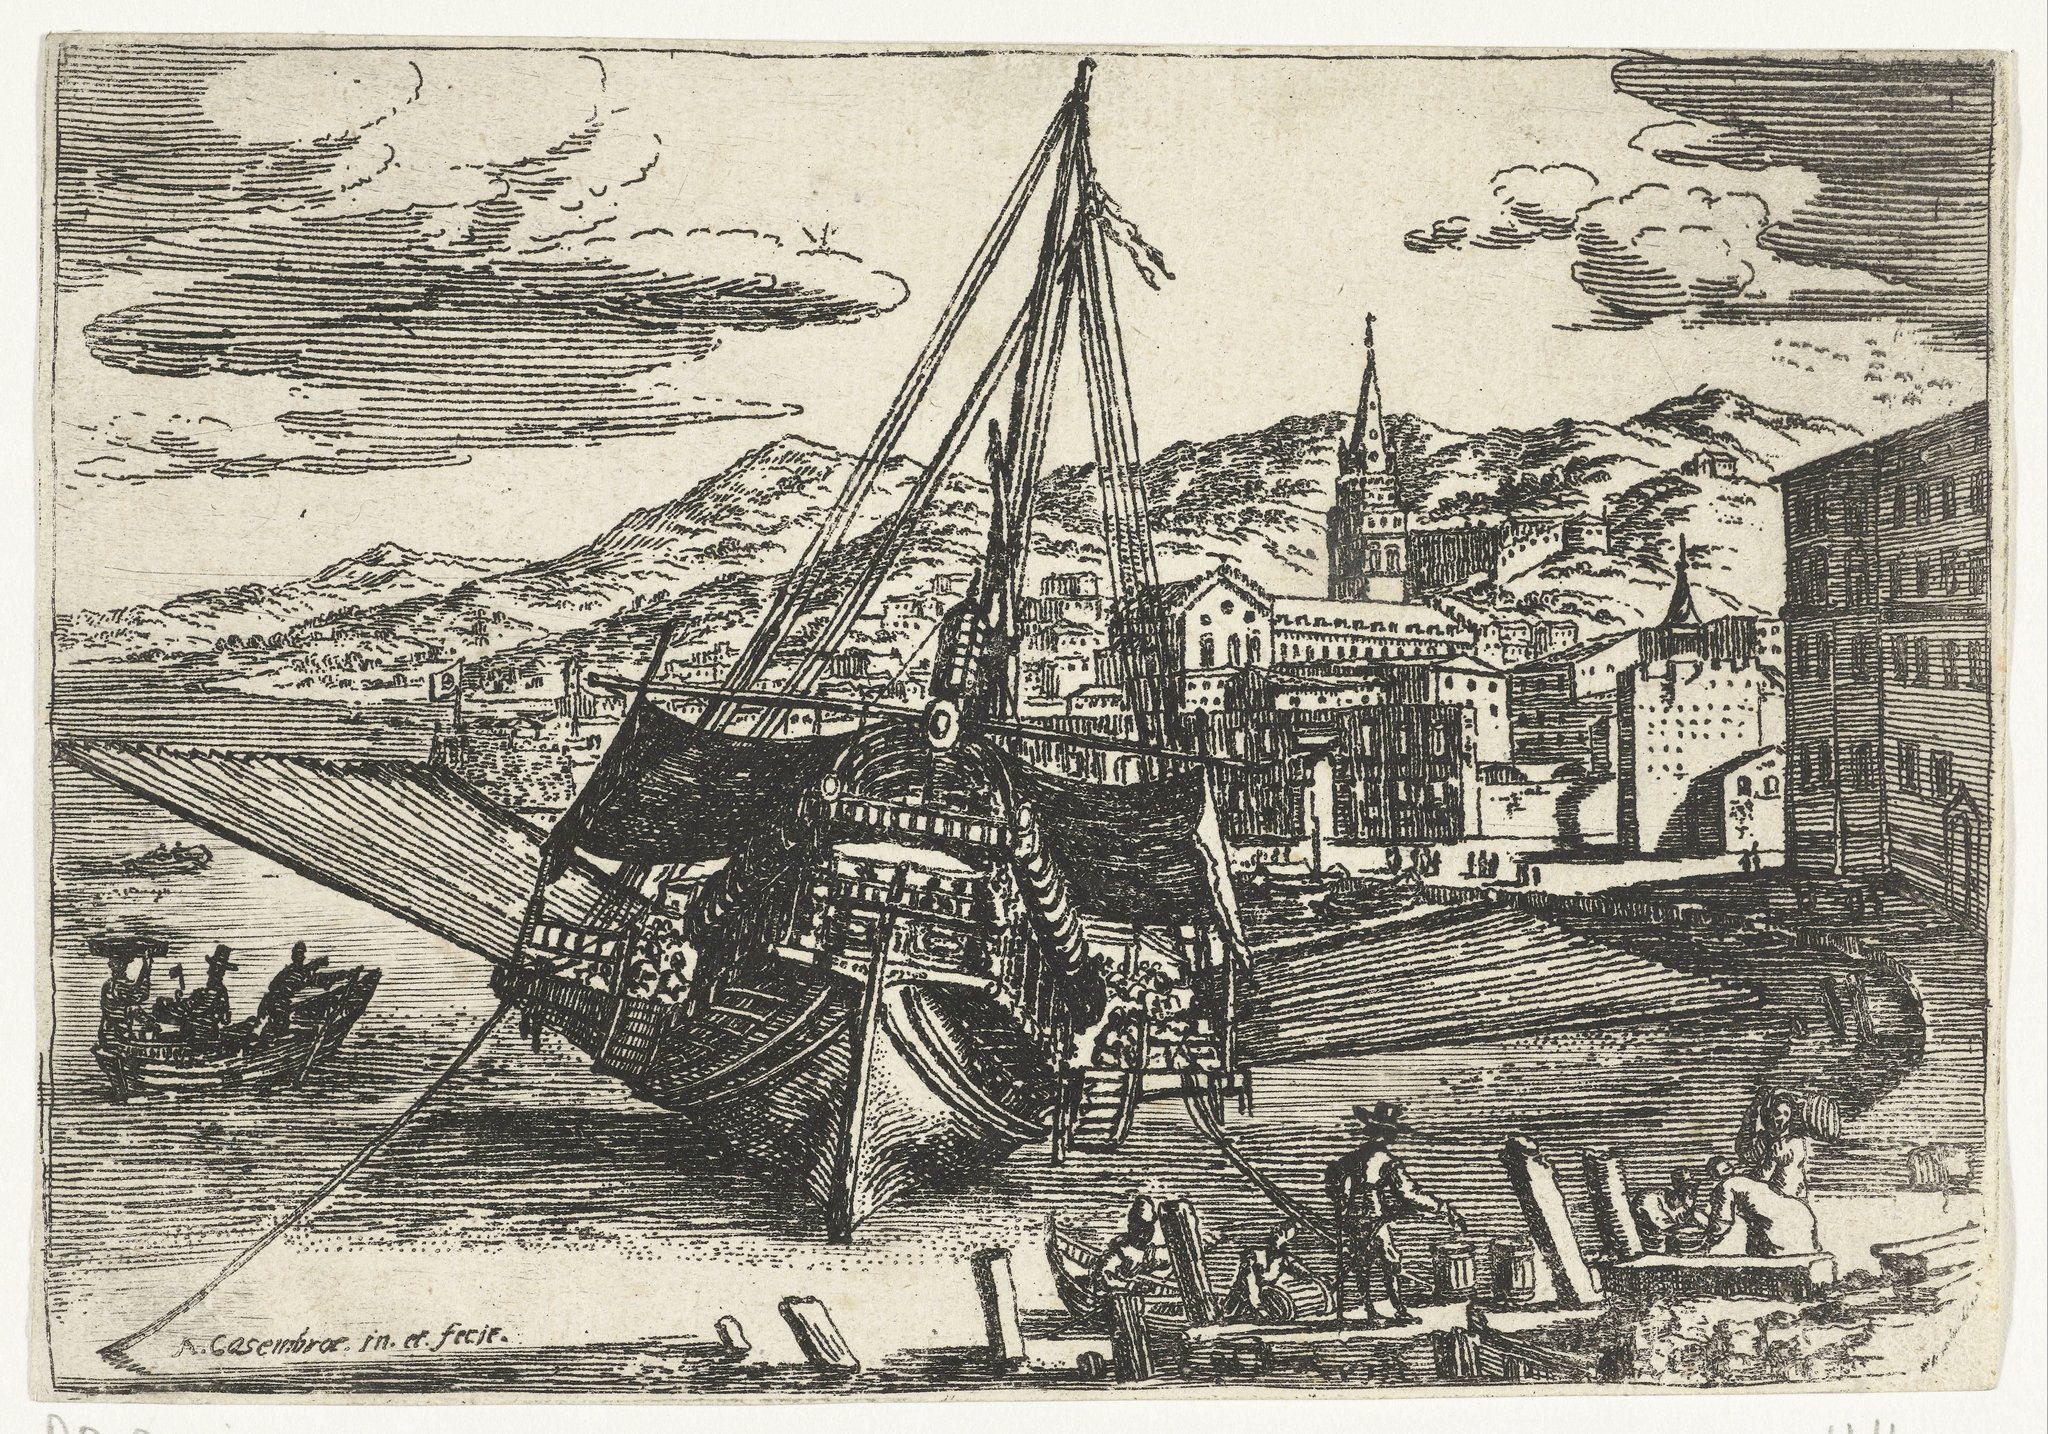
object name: print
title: Gezichten van de haven van Messina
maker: abraham de casembroot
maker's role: draughtsman, print maker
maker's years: 1573-1658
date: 1603-1658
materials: paper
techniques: etching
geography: southern netherlands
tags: harbour, warfare; military affairs (+ oared ships, e.g.: galley), quay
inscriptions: collector's mark: Lugt 2166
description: Gezicht op een kade van de haven van Messina. Op de voorgrond ligt een galei voor anker. Een roeiboot met passagiers vaart naar het schip toe. Prent uit serie van dertien prenten met gezichten van de haven van Messina